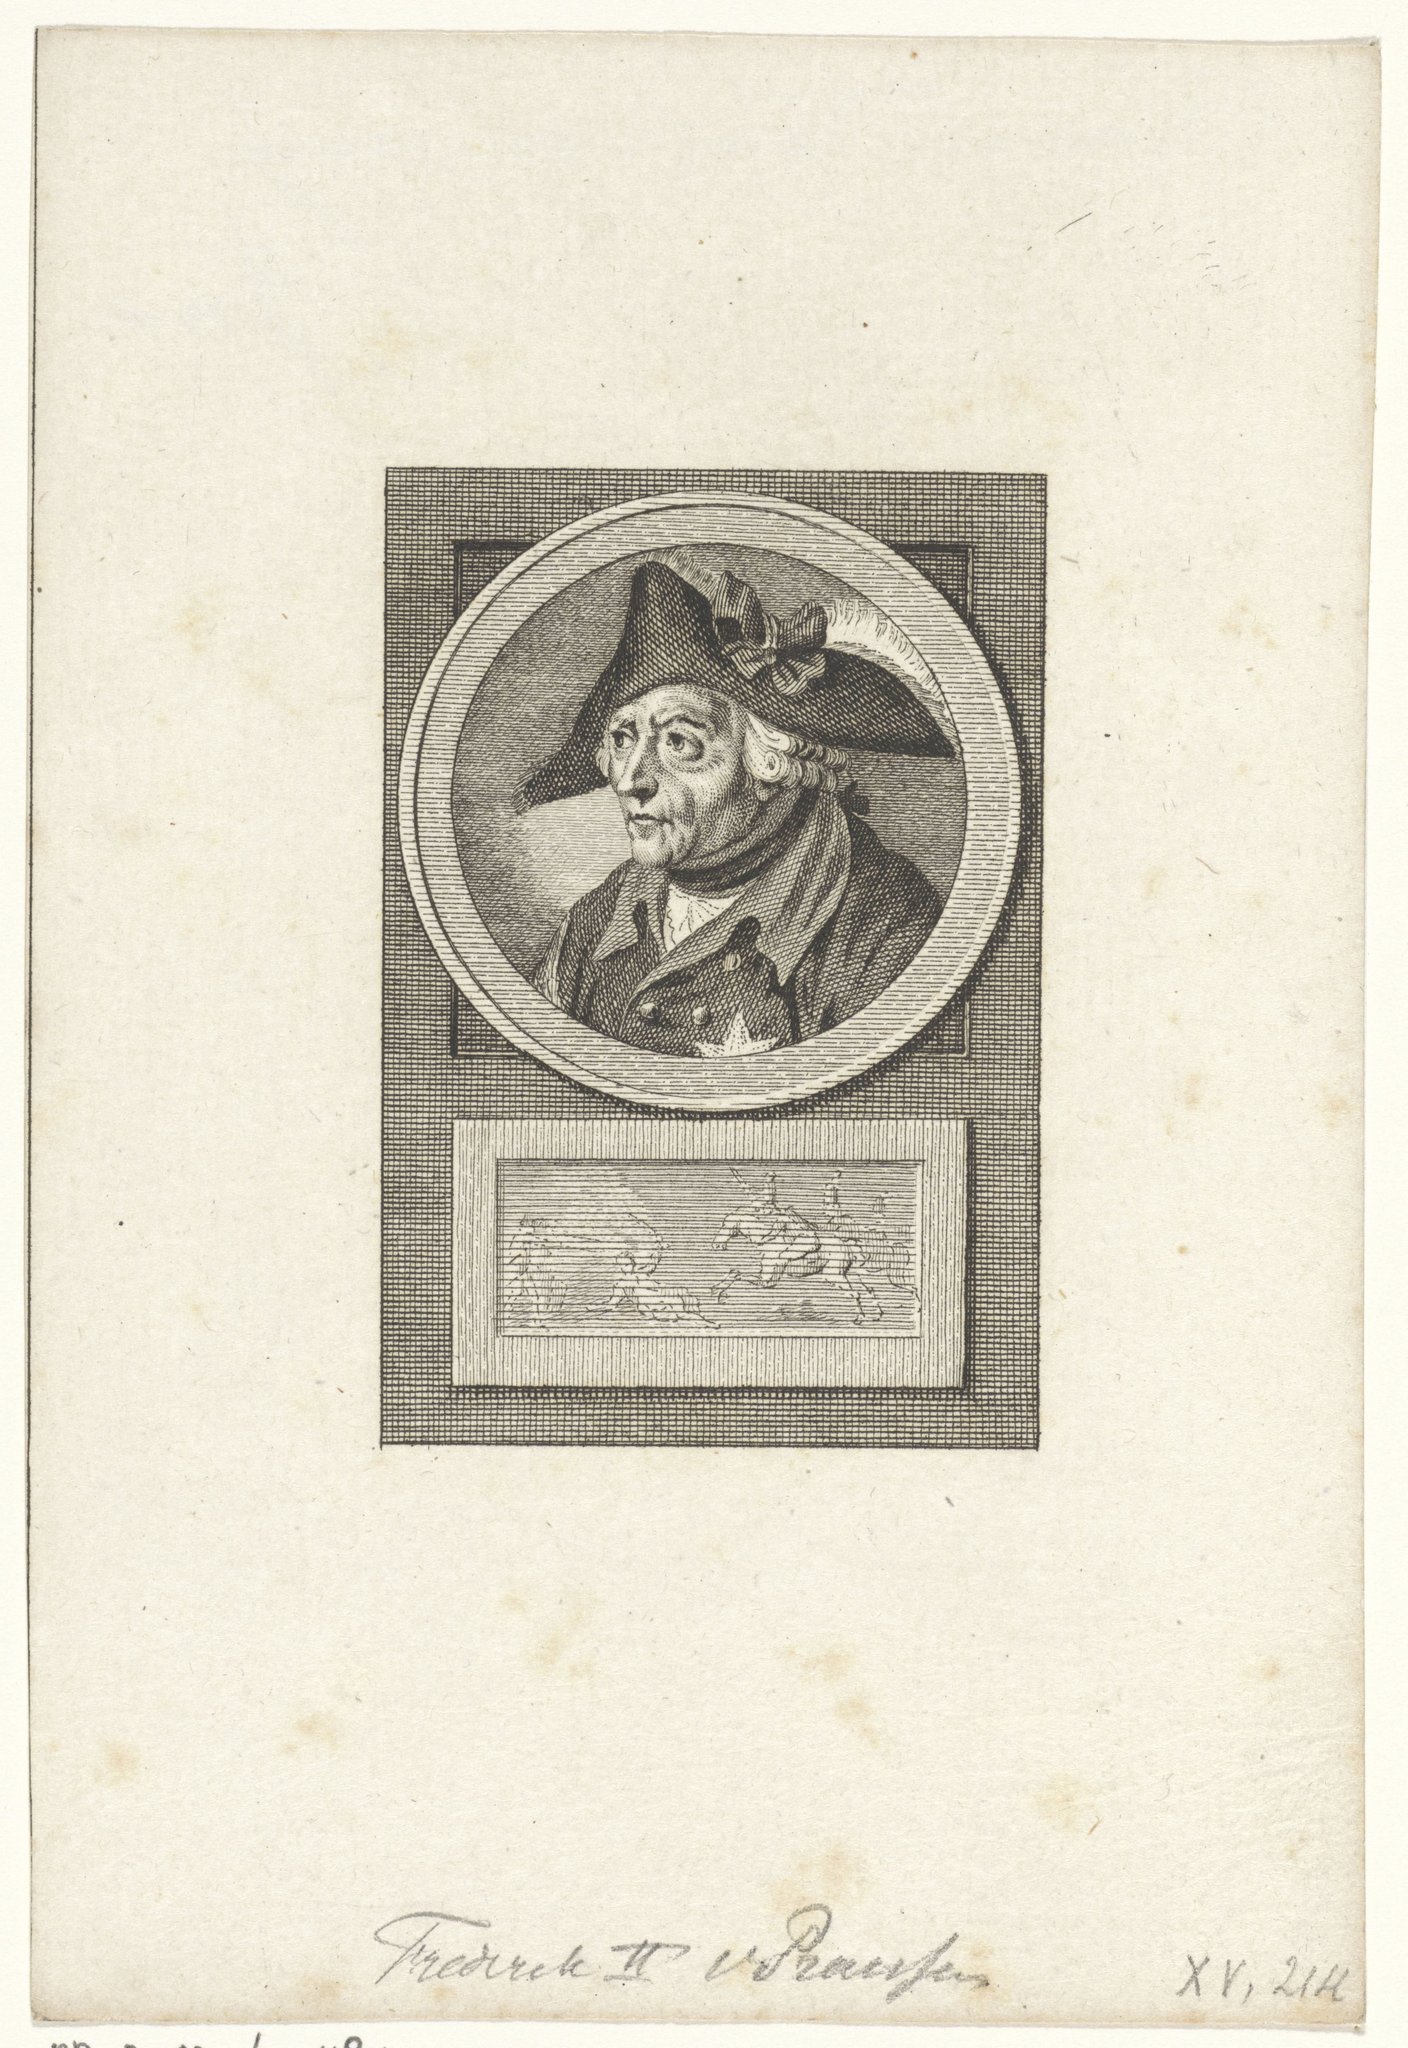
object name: print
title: Portret van Frederik de Grote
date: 1783-1795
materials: paper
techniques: engraving, etching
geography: amsterdam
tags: berlin, frederick ii (king of prussia), battle (+ cavalry, horsemen)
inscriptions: inscription: ‘Frederik II v.Pruissen XV, 214’, collector's mark: Lugt 2228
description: Latere staat prent gebruikt in: Fokke, Jan. Geschiedenissen der Vereenigde Nederlanden voor de vaderlandsche jeugd Ie-XXVste deel. Amsterdam: Johannes Allart, 1783-1795. Deel XV.